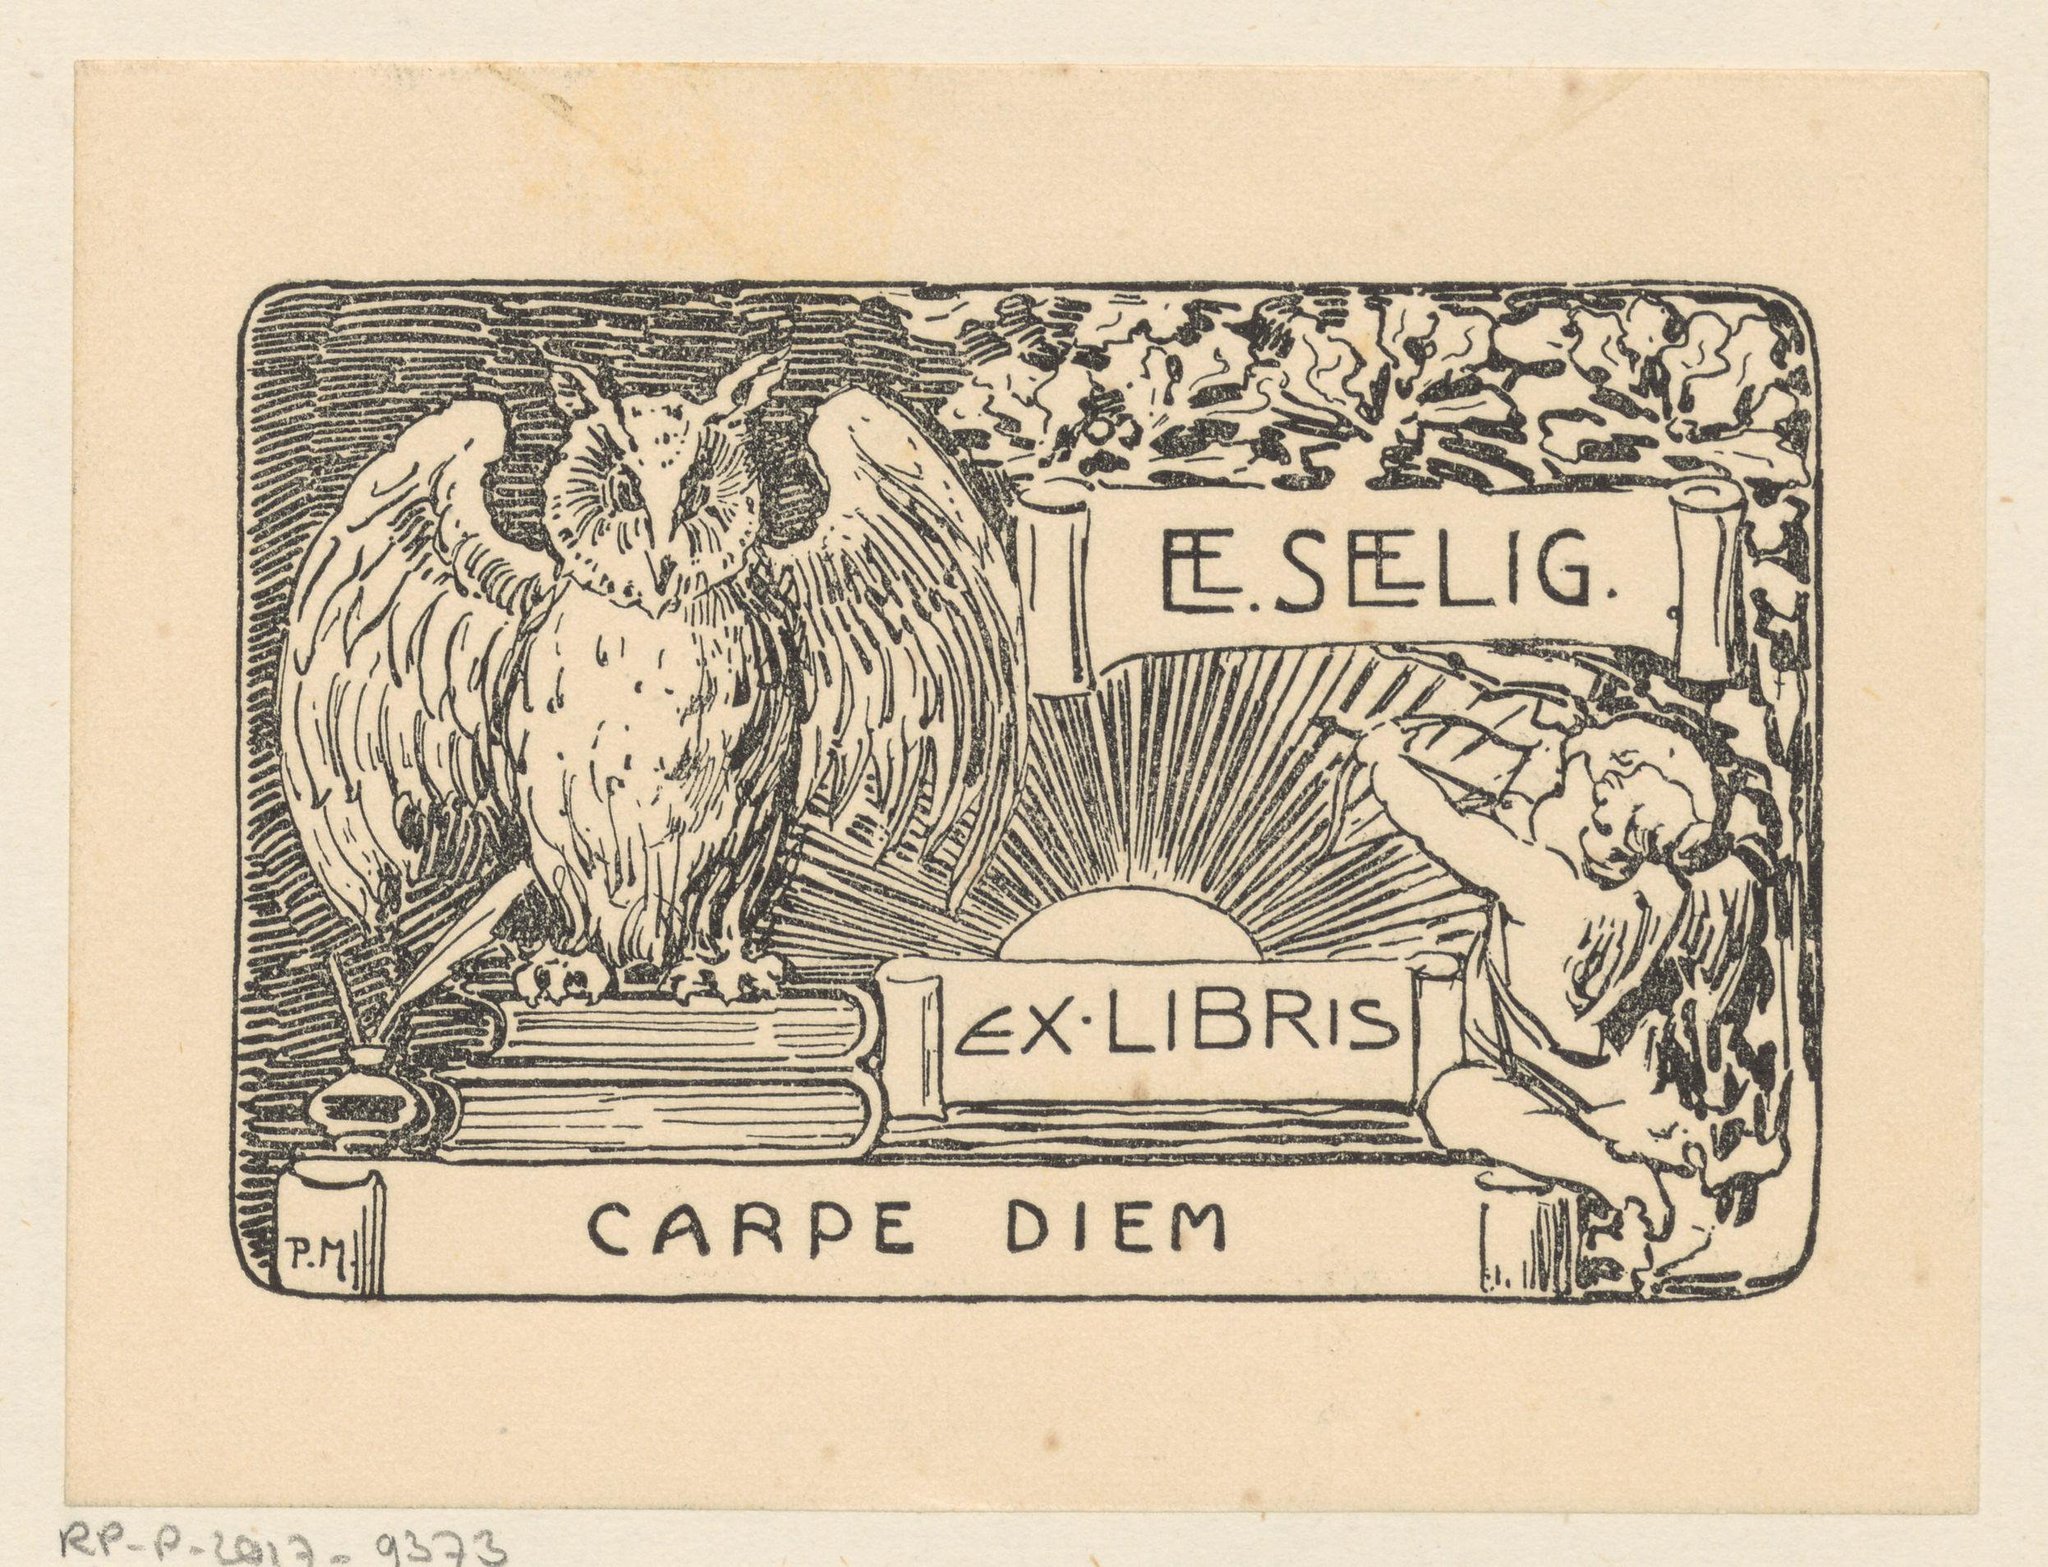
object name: bookplate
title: Carpe diem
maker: piet mondriaan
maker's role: print maker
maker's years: 1872-1944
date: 1882-1930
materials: paper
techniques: lithograph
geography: netherlands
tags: painter, draughtsman, owls, sunset, cupids: 'amores', 'amoretti', 'putti'